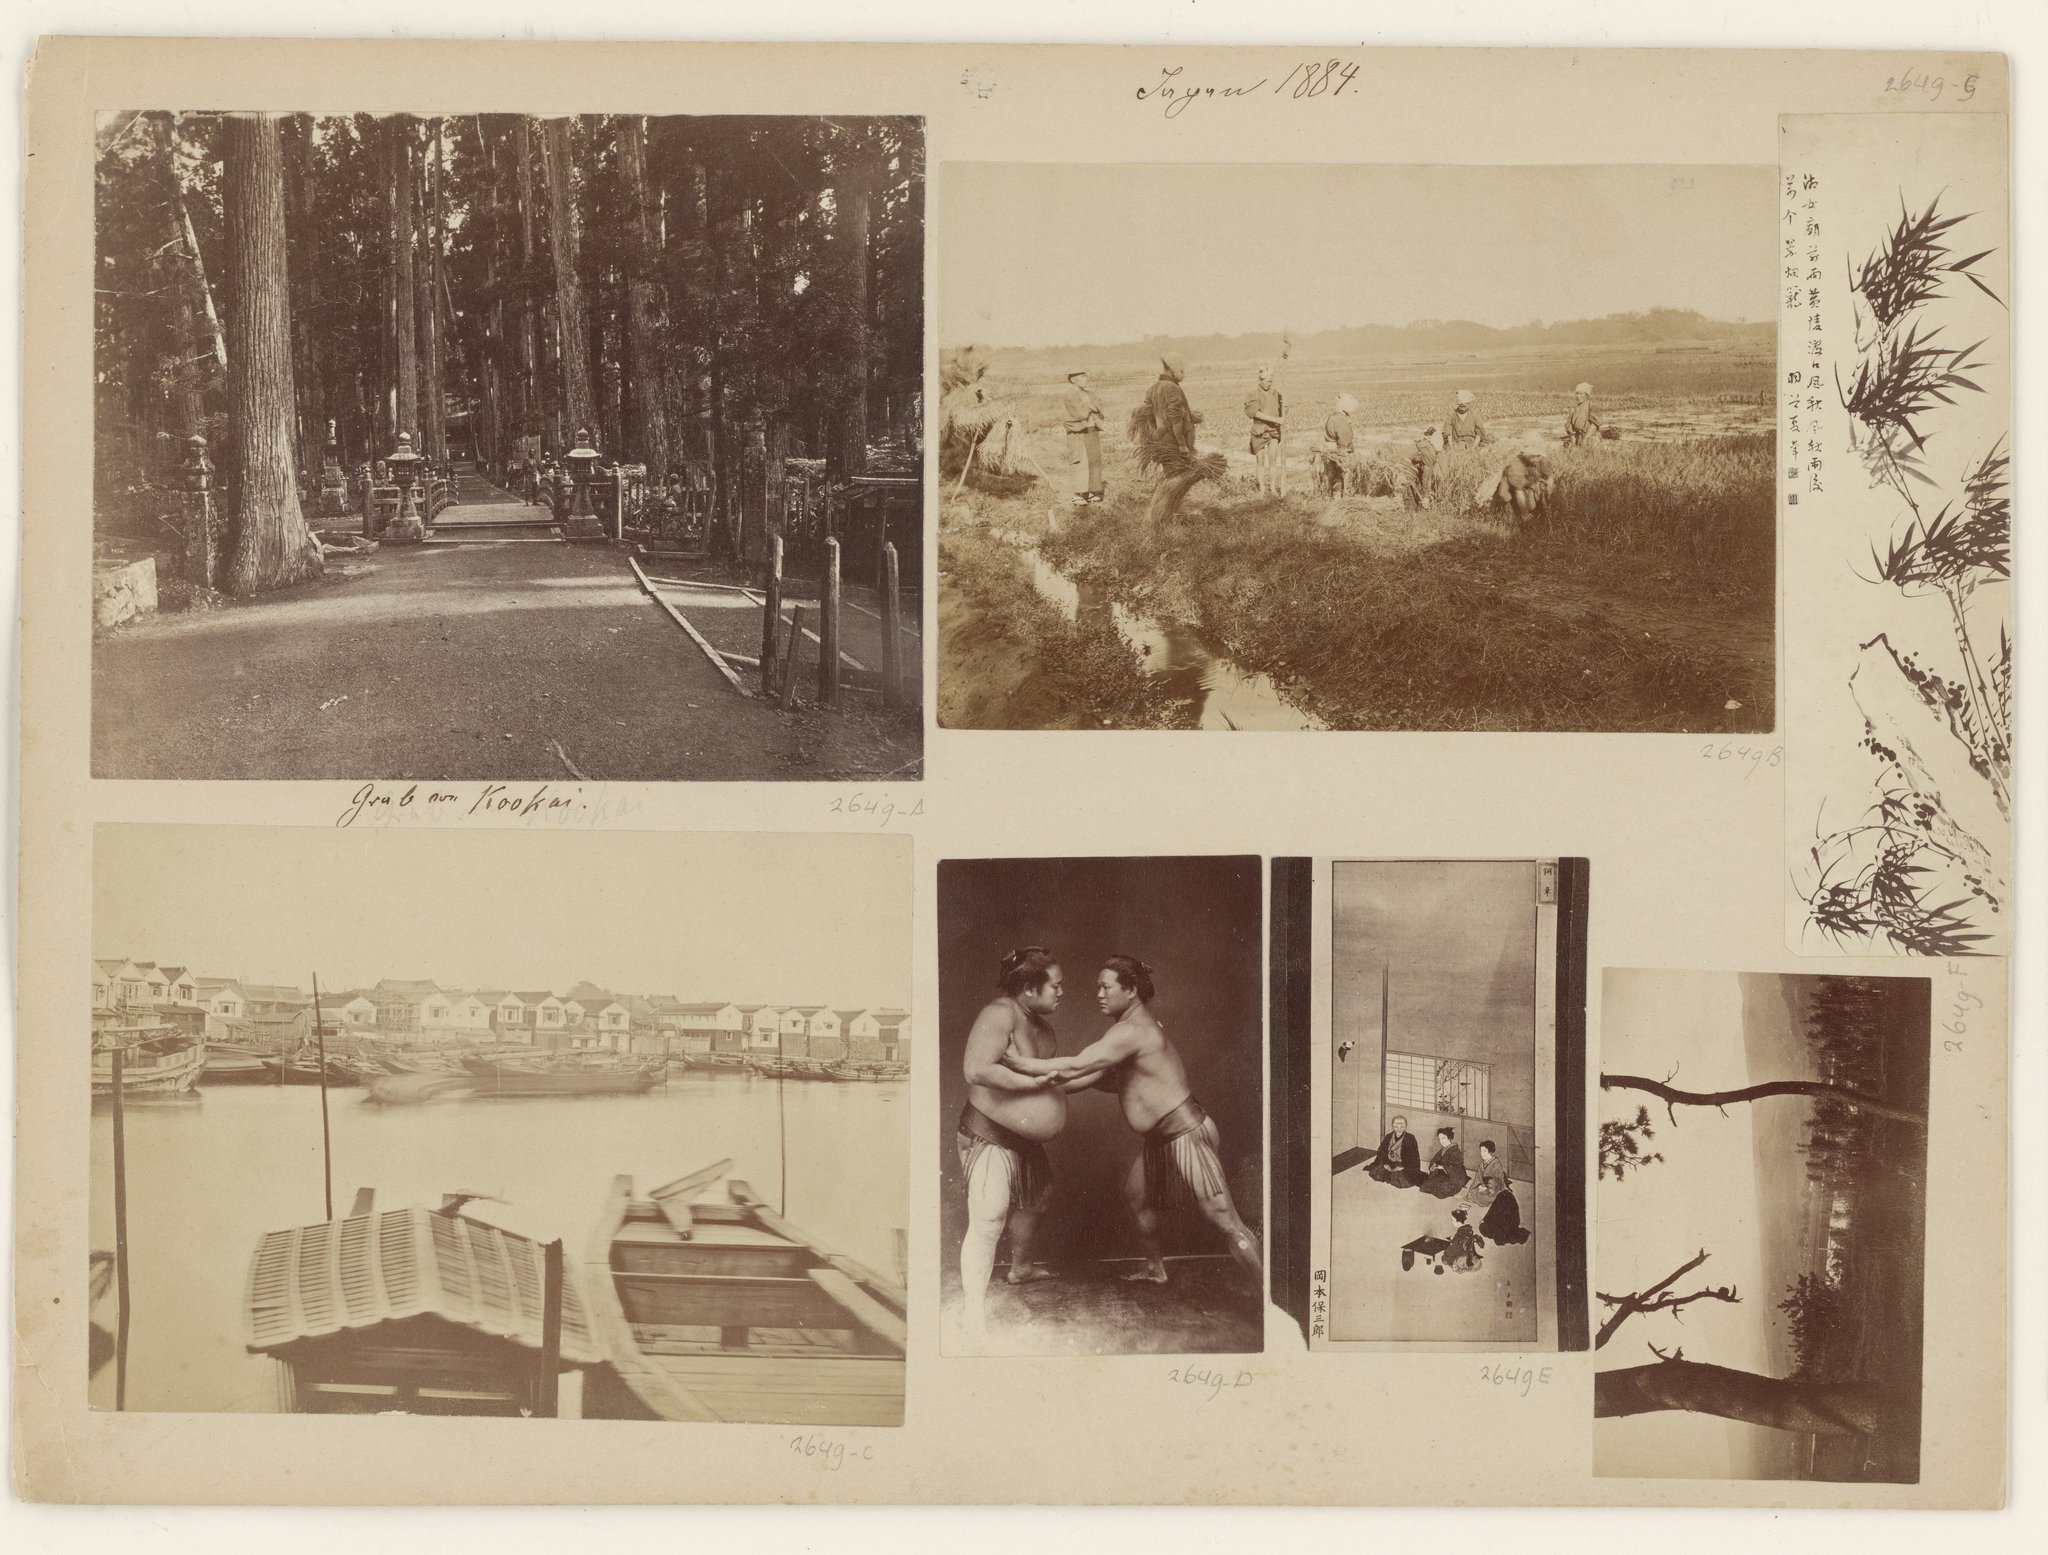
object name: photograph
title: Fotoreproductie van een schildering van bamboe, links enkele Japanse tekens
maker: Anonymous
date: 1884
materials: cardboard, paper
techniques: albumen print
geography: japan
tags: trees, japan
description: Onderdeel van een blad met zeven foto's.